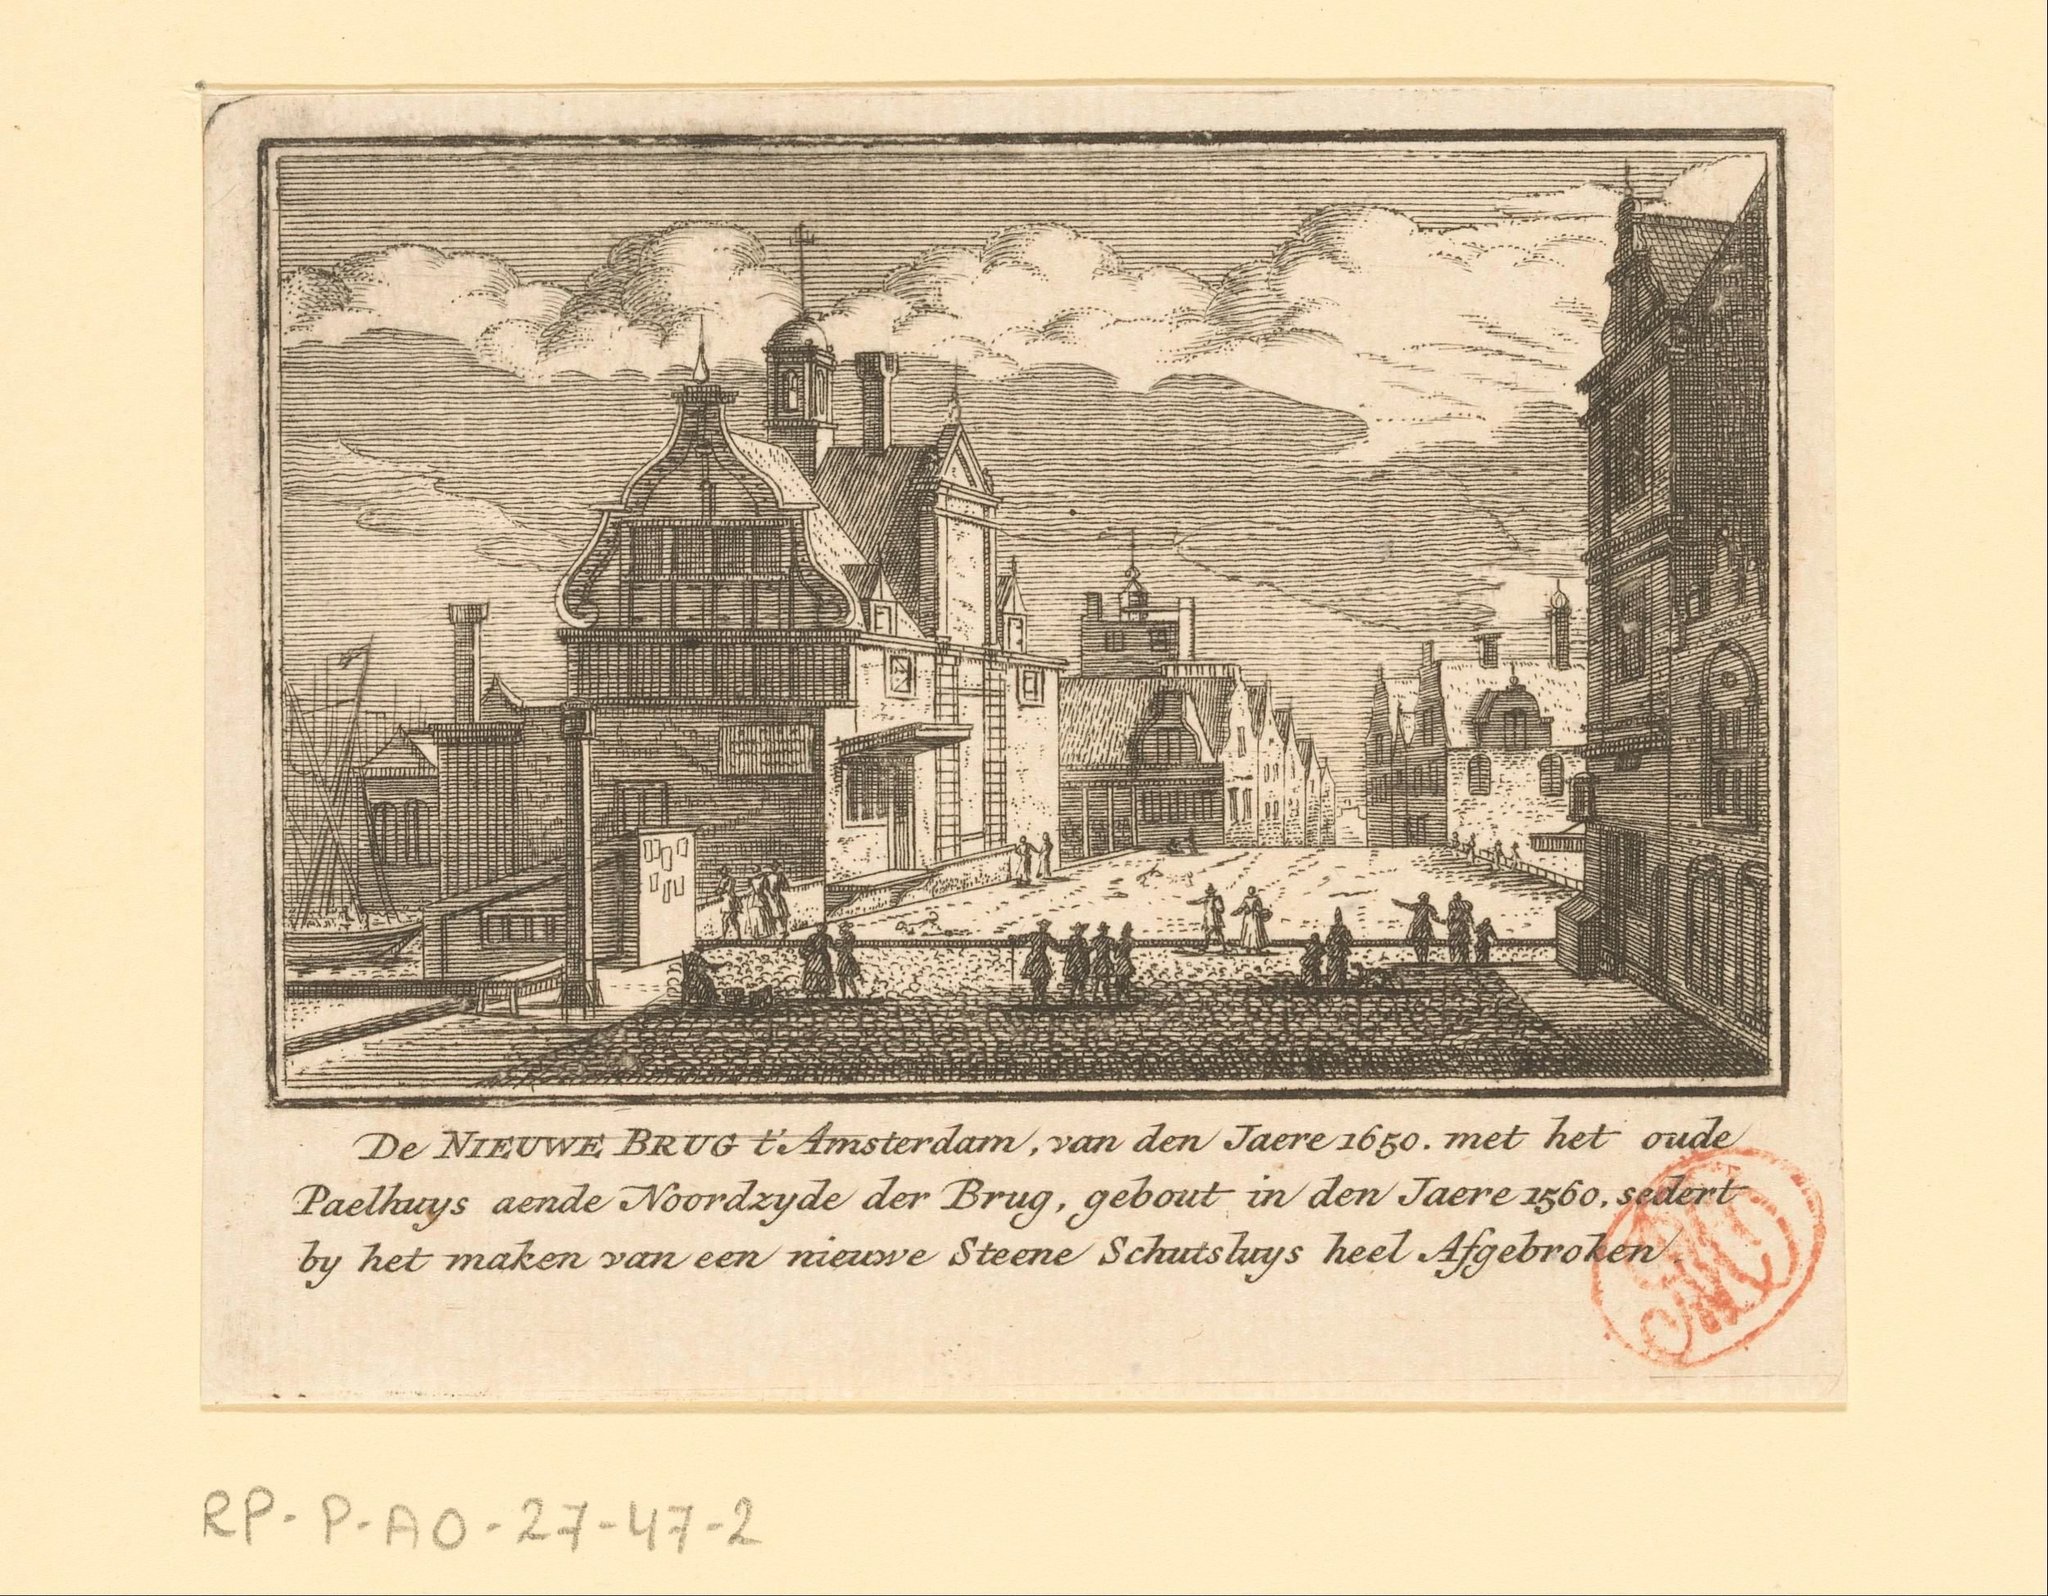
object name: print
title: Gezicht op het Paalhuis en de Nieuwe Brug te Amsterdam, 1650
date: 1726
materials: paper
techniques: engraving, etching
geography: amsterdam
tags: bridge in city across river, canal, etc. (+ city(-scape) with figures, staffage), post-office, taxes and financial administration, street (+ city(-scape) with figures, staffage)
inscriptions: collector's mark: Lugt 195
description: Gezicht op het Paalhuis aan de noordzijde van de Nieuwe Brug te Amsterdam, in de situatie omstreeks 1650. Gezien vanaf de Texelse Kade (later Prins Hendrikkade). Rechtsvoor een huis aan de Texelse Kade en de zijgevel van het eerste huis van het Damrak.